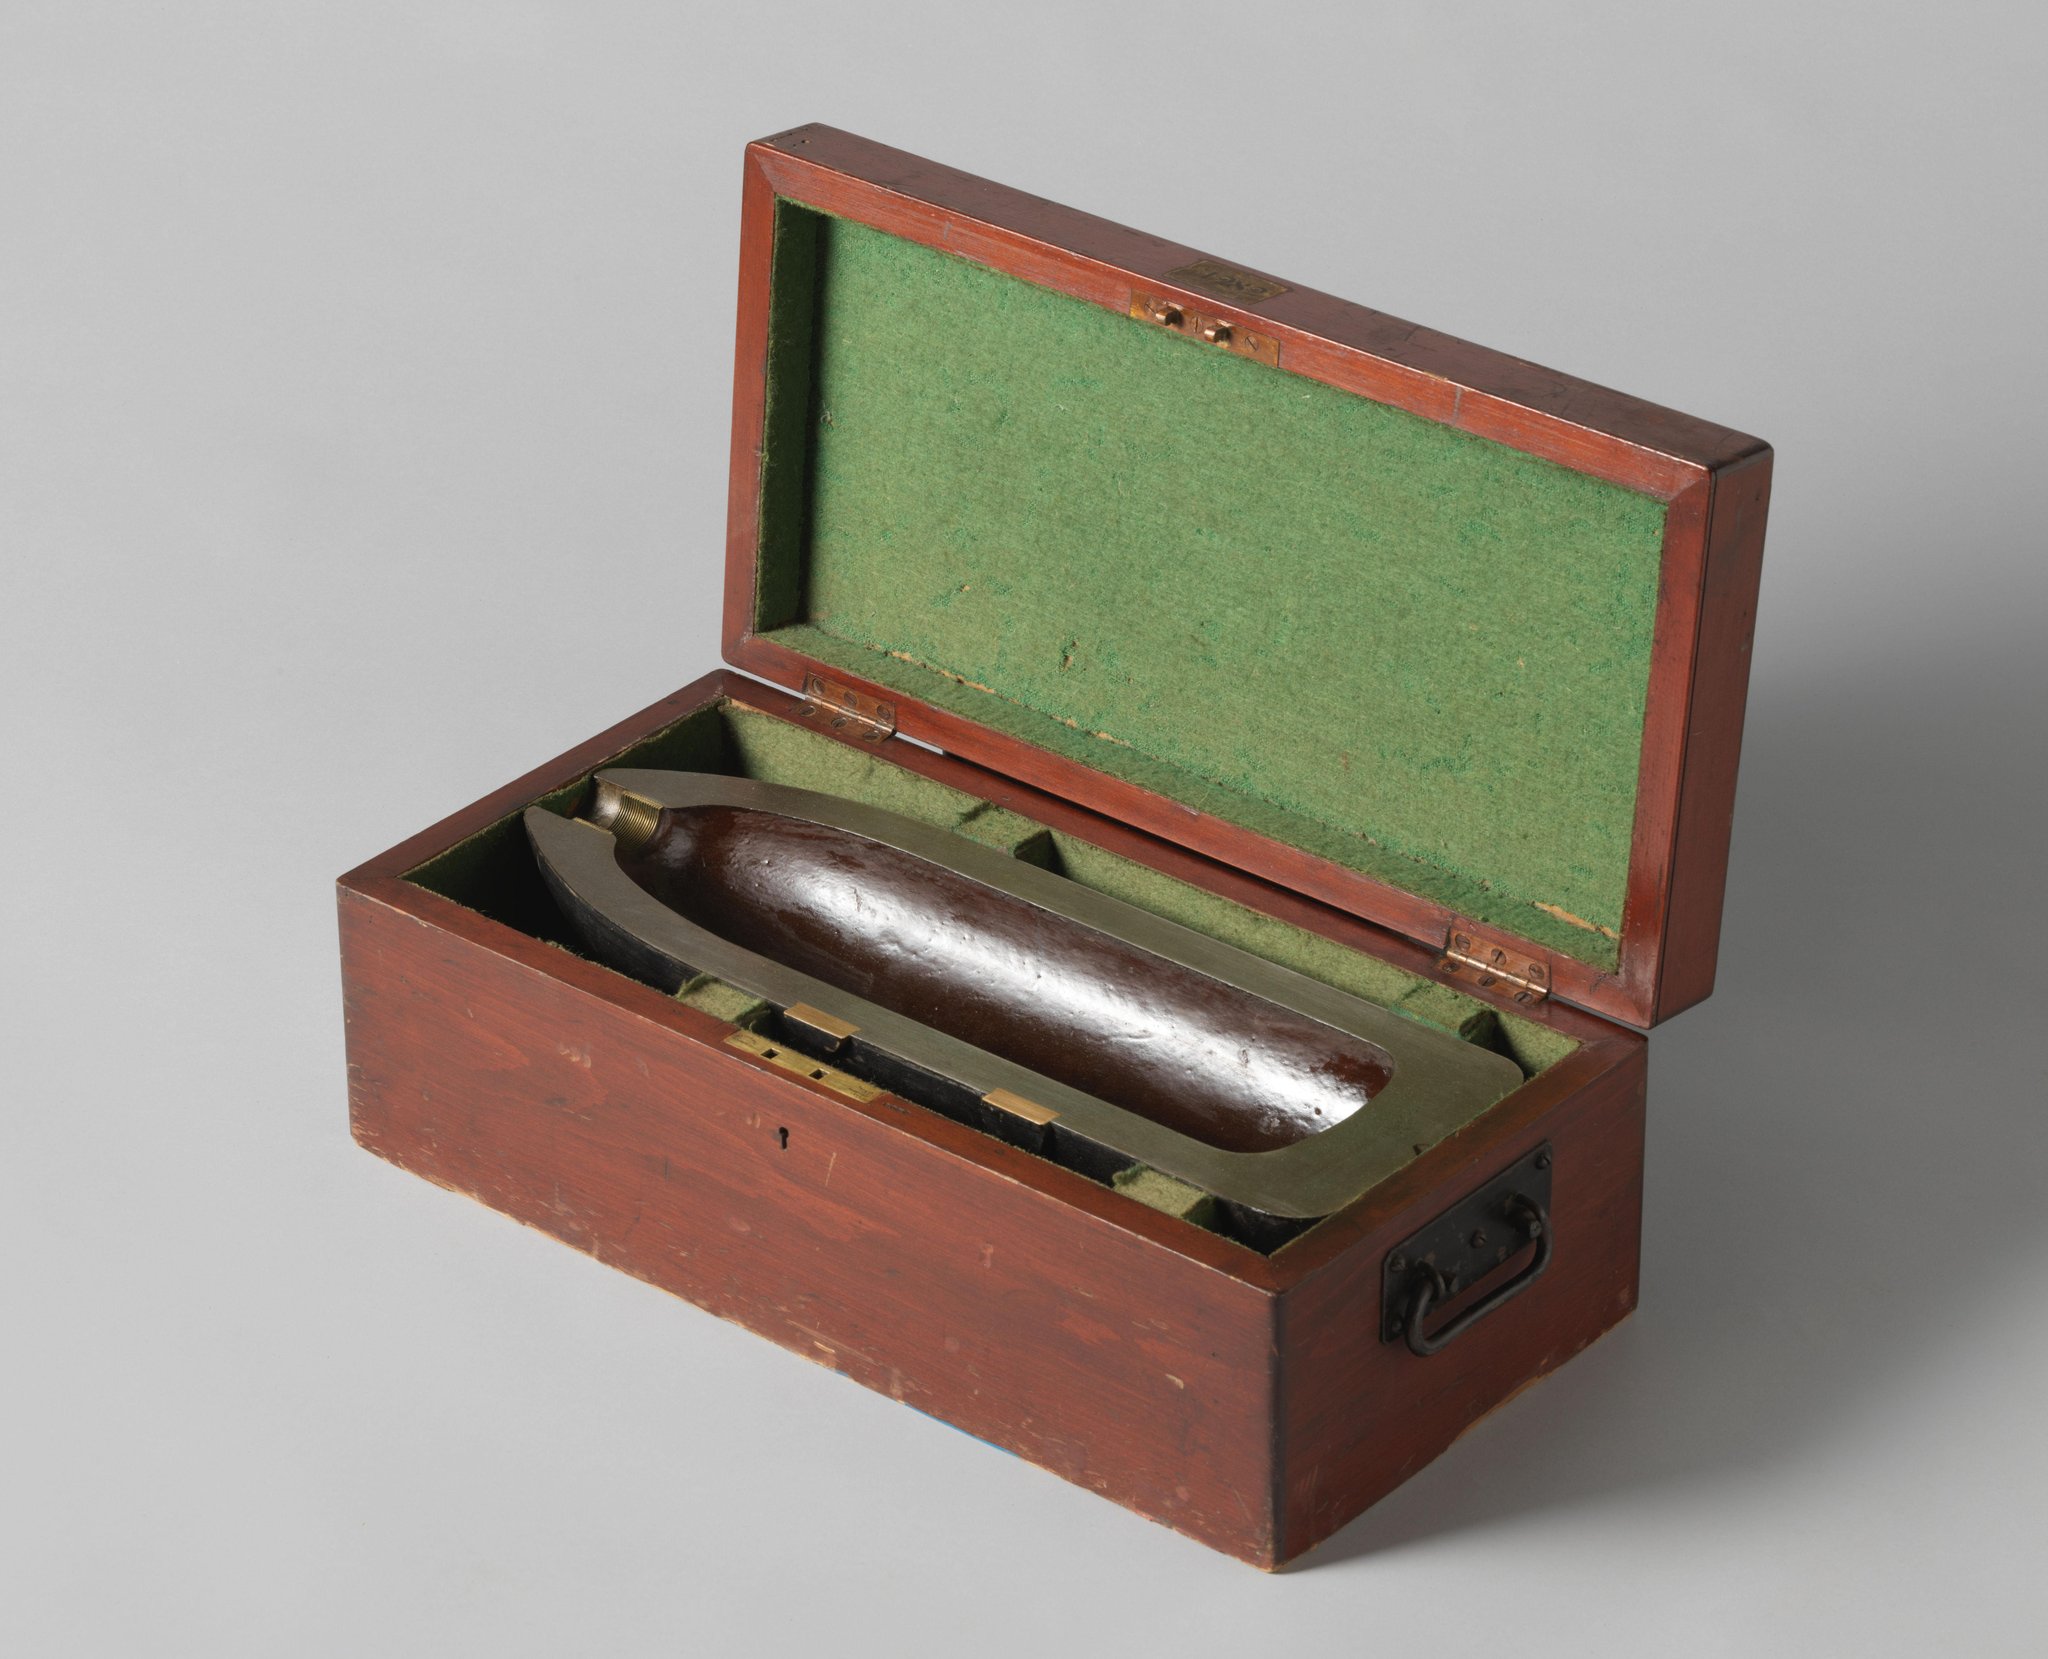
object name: chest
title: 18-cm Shell in Wooden Box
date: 1868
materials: brass, bronze, iron, lead, wood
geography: newcastle upon tyne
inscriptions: inscription, on the lock of the box: ‘John Shaw & Sons / Wolverhampton / Safety patent lever lock.’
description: Een halve overlangs doormidden gezaagde puntvormige 18 cm granaat, in een houten kist. De granaat is 51.5 cm lang en heeft een kaliber van 176 mm. Hij heeft twee ringen ingeperste nokken voor een getrokken loop met drie trekkende velden en is hol; in de neus een buisgat. Bovenin zijn ondiepe gaten voor de munitie-kraan aangebracht.